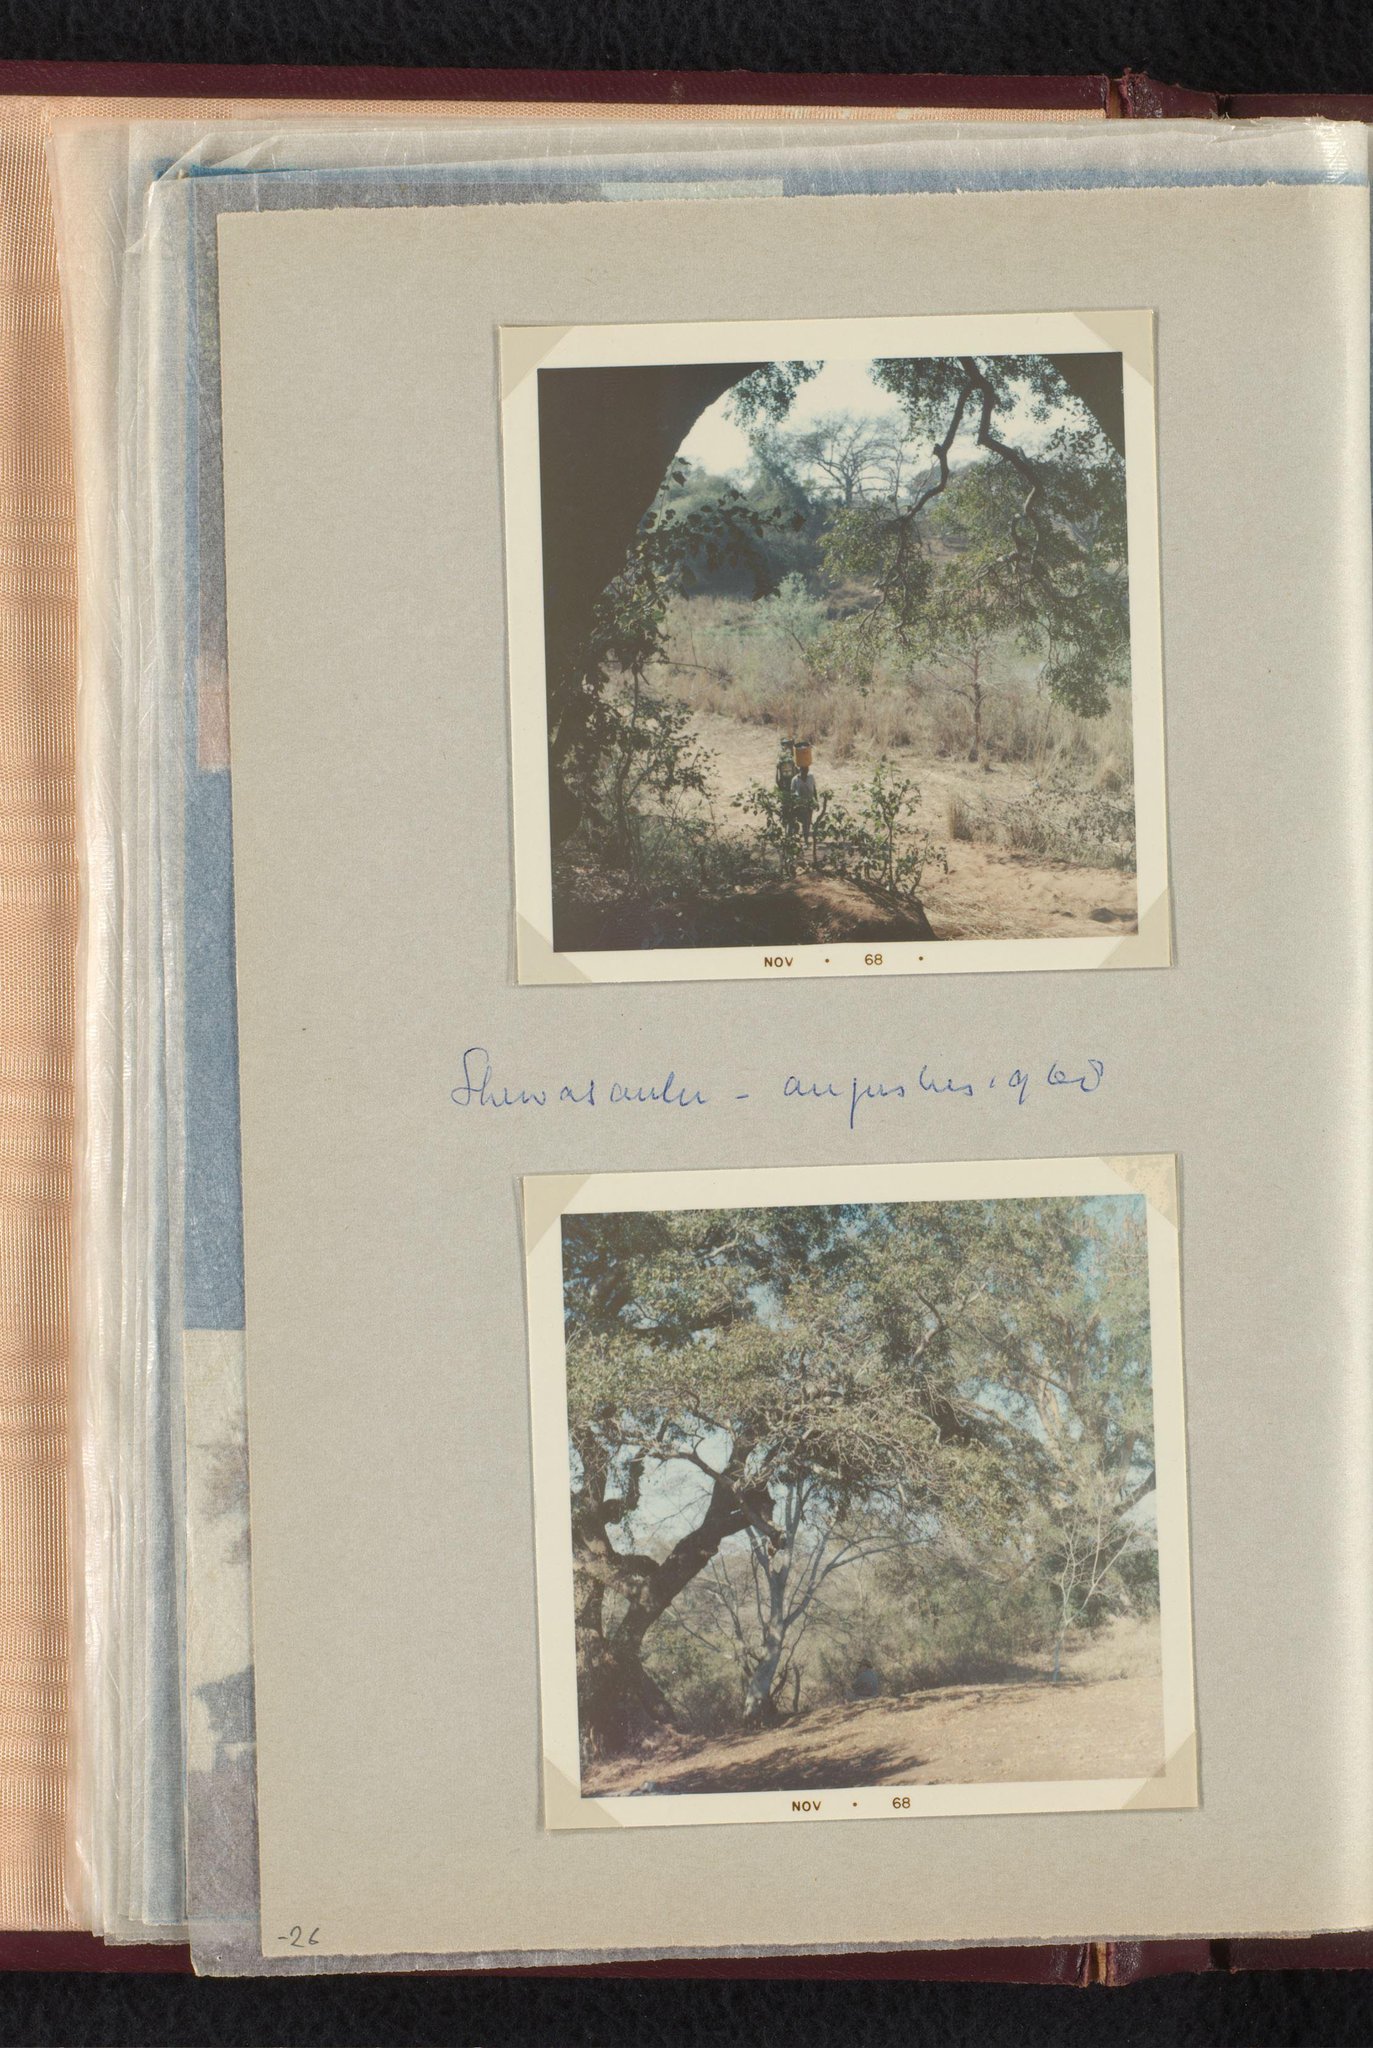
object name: album leaf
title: Twee Zuid-Afrikaanse mensen met draagmanden op het hoofd, bij Shewasaulu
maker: willem jacob van den berg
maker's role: boer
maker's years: 1902-1983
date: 1911-1968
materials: paper, cardboard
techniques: chromogenic print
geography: shewasaulu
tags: carrying something on the head or on the shoulders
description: Deze foto's zijn onderdeel van een album.